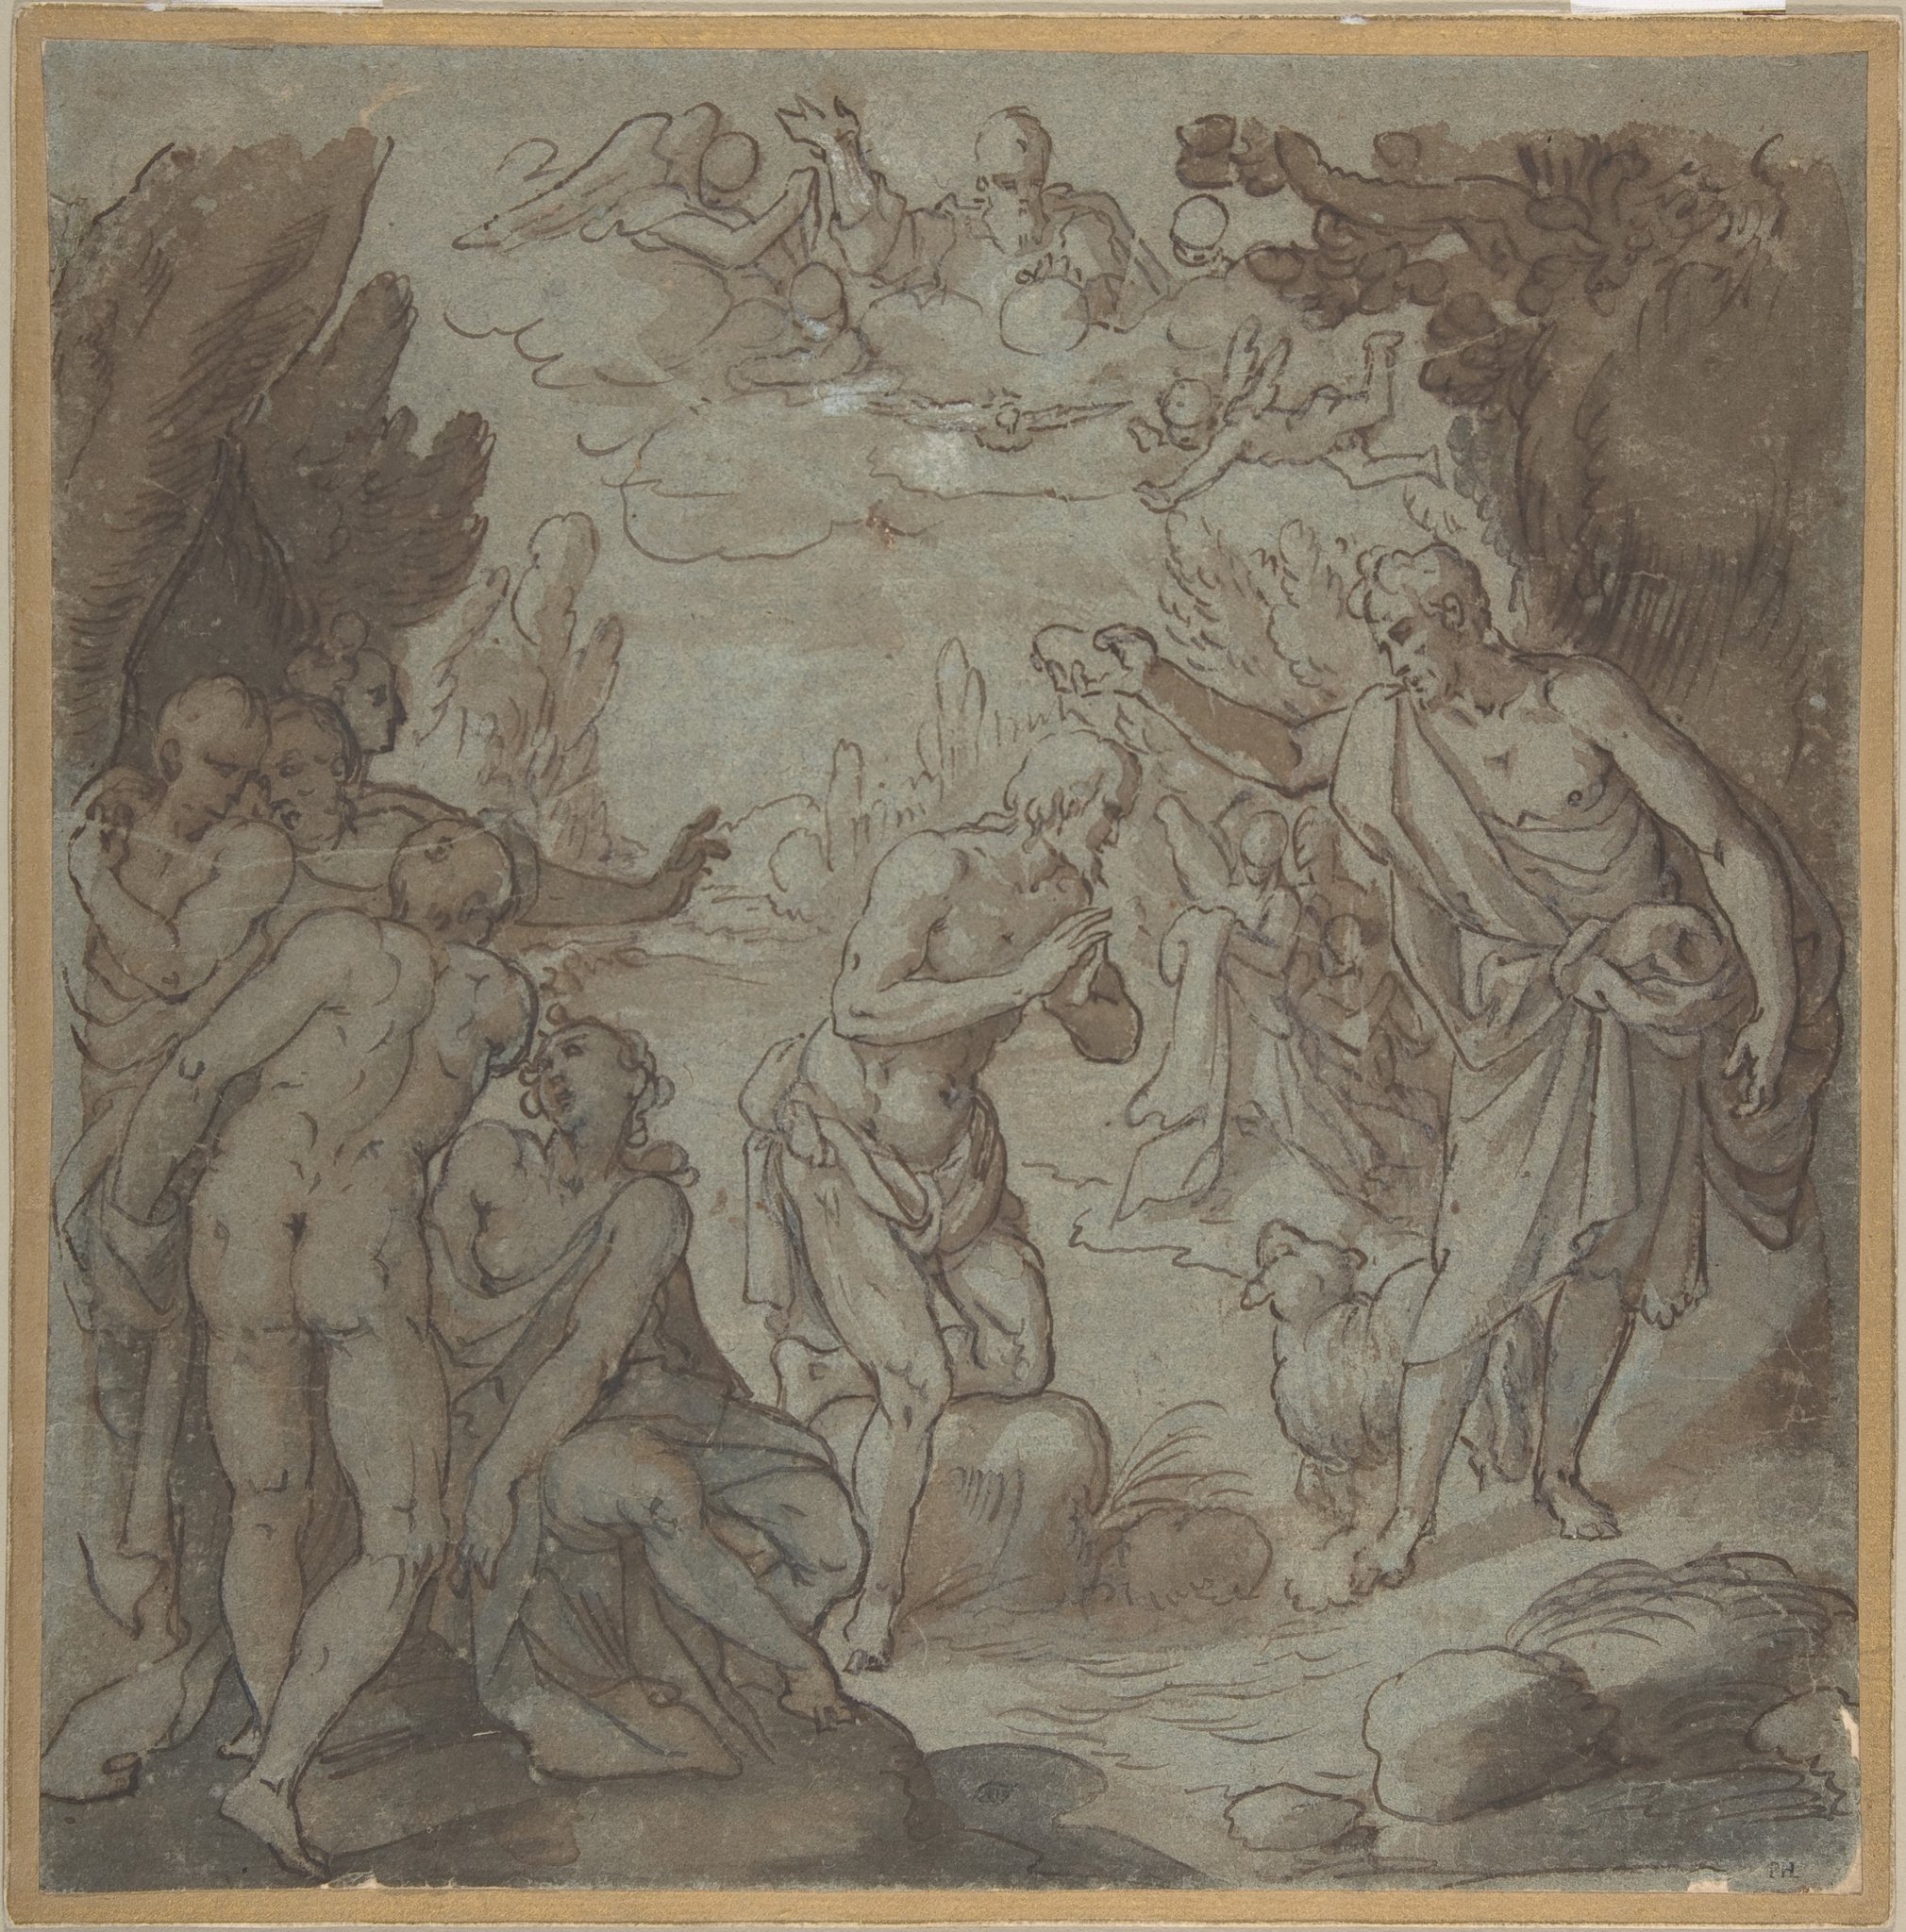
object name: drawing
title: Baptism of Christ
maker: hans rottenhammer i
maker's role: artist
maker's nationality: german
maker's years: 1564-1625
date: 1567-1700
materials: ink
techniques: brush, pen, wash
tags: angels,baptism of christ